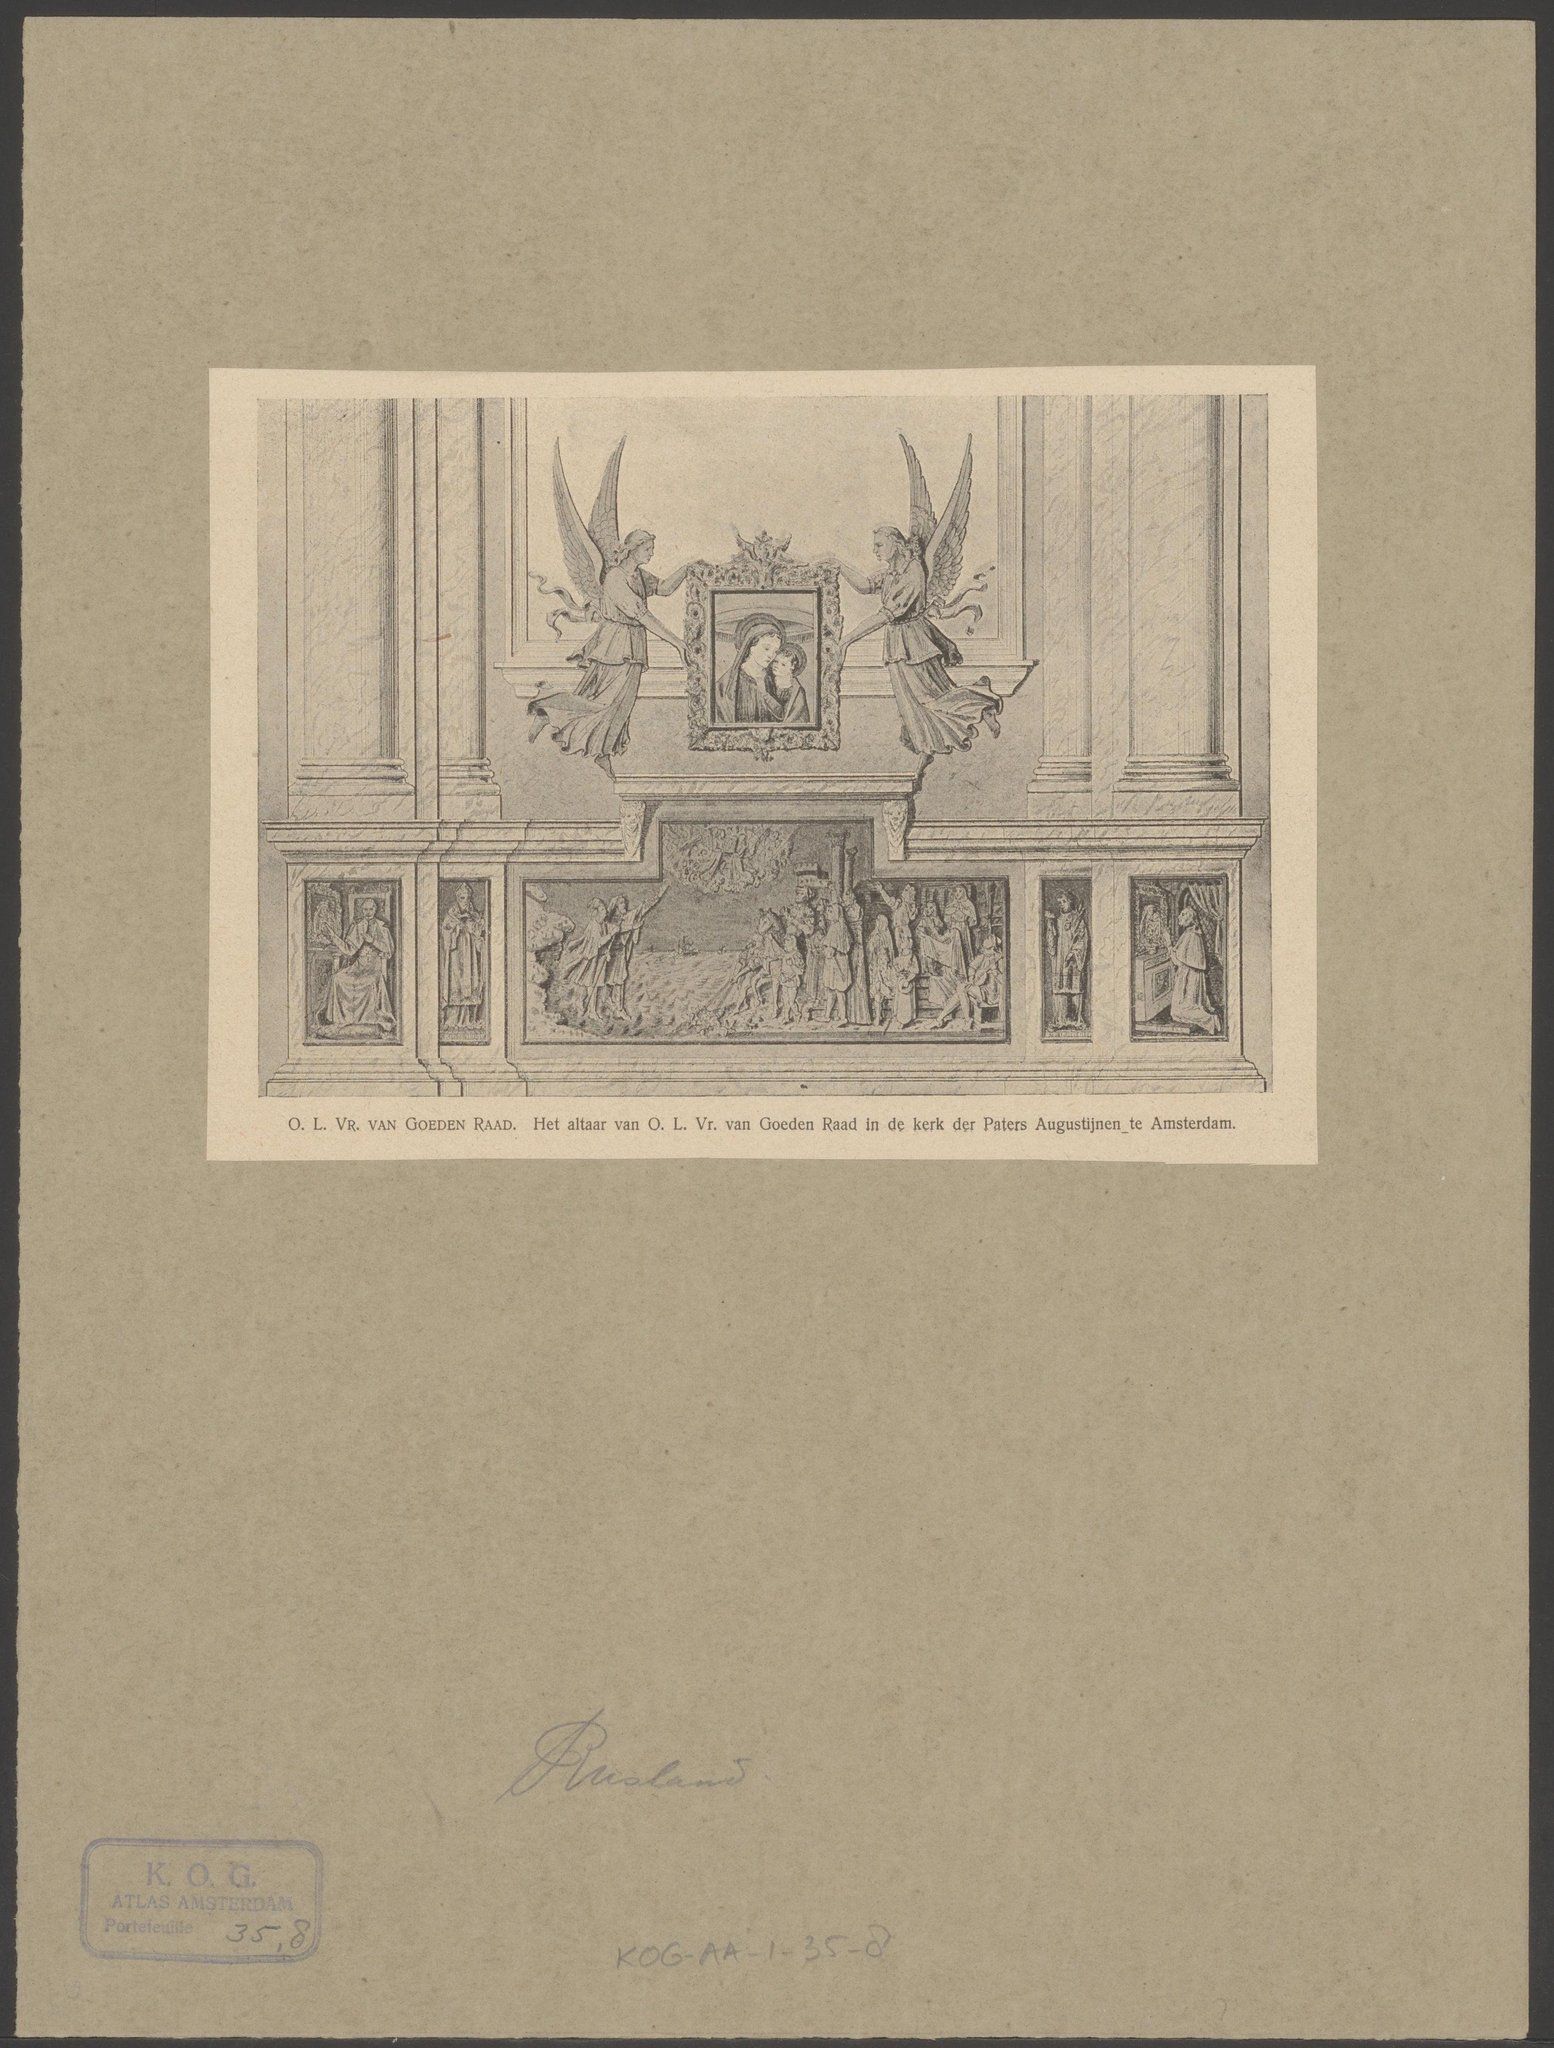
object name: newspaper clipping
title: Altaar van Onze Lieve Vrouw van Goede Raad in de Star (Sint Augustinuskerk) te Amsterdam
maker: Anonymous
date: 1908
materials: paper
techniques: letterpress printing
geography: amsterdam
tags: madonna: i.e. mary with the christ-child, roman catholic church, mary devotion, altar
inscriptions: collector's mark: ‘35,8’ Lugt 1641b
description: Ook wel bekend als De Ster of De Spin. Onderwerpsrubriek binnen de Atlas Amsterdam: R.K. Gemeenten: Sint Nicolaaskerk t/m Willibrordus (Rustenburgerstraat).